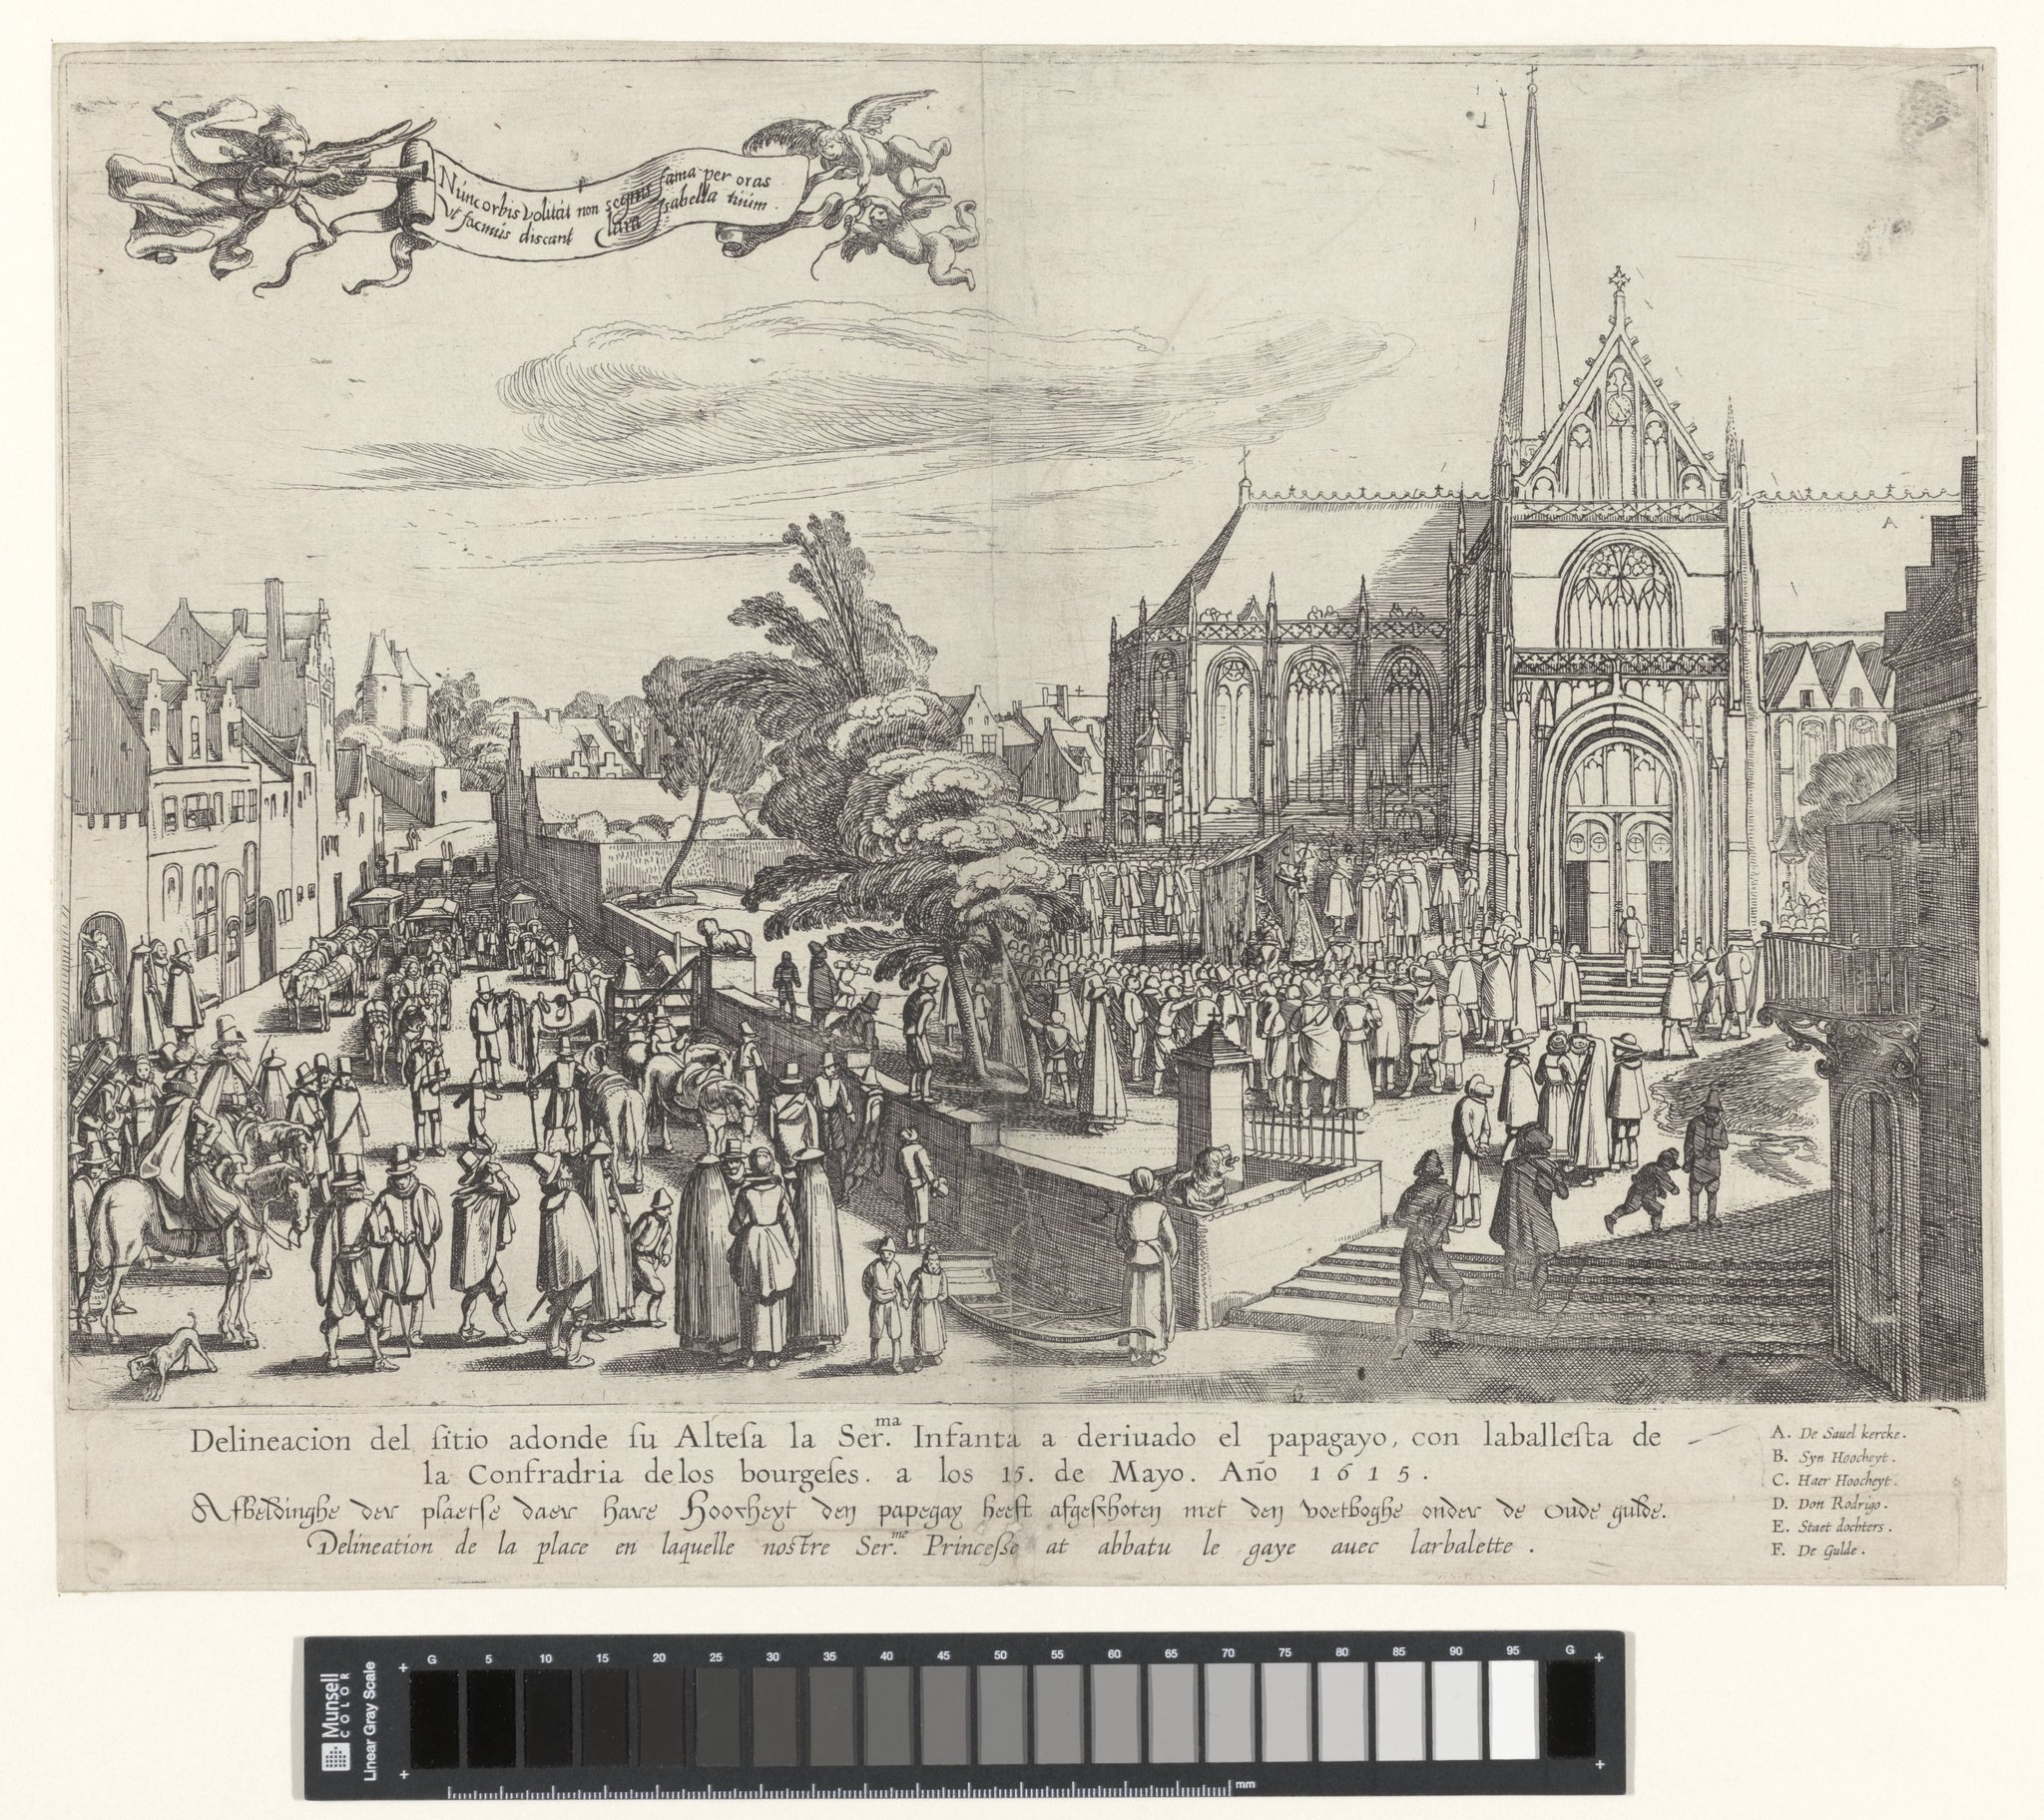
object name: print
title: Afbeldinghe der plaetse daer hare hoocheyt den paegay heeft afgeschoten met den voetboghe onder de oude gulde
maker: Anonymous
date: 1615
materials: paper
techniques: engraving, etching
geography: low countries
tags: infante van spanje isabella clara eugenia, shooting-the-bird (on a high pole)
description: Isabella Clara Eugenia schiet naar de papegaai bij de Onze-Lieve-Vrouw-ter-Zavelkerk te Brussel, 15 mei 1615. Grote menigte verzameld op het plein voor de kerk en op straat. In de lucht engelen met een banderol met opschrift in het Latijn. Aparte plaat met het onderschrift de titels en de legenda A-F.